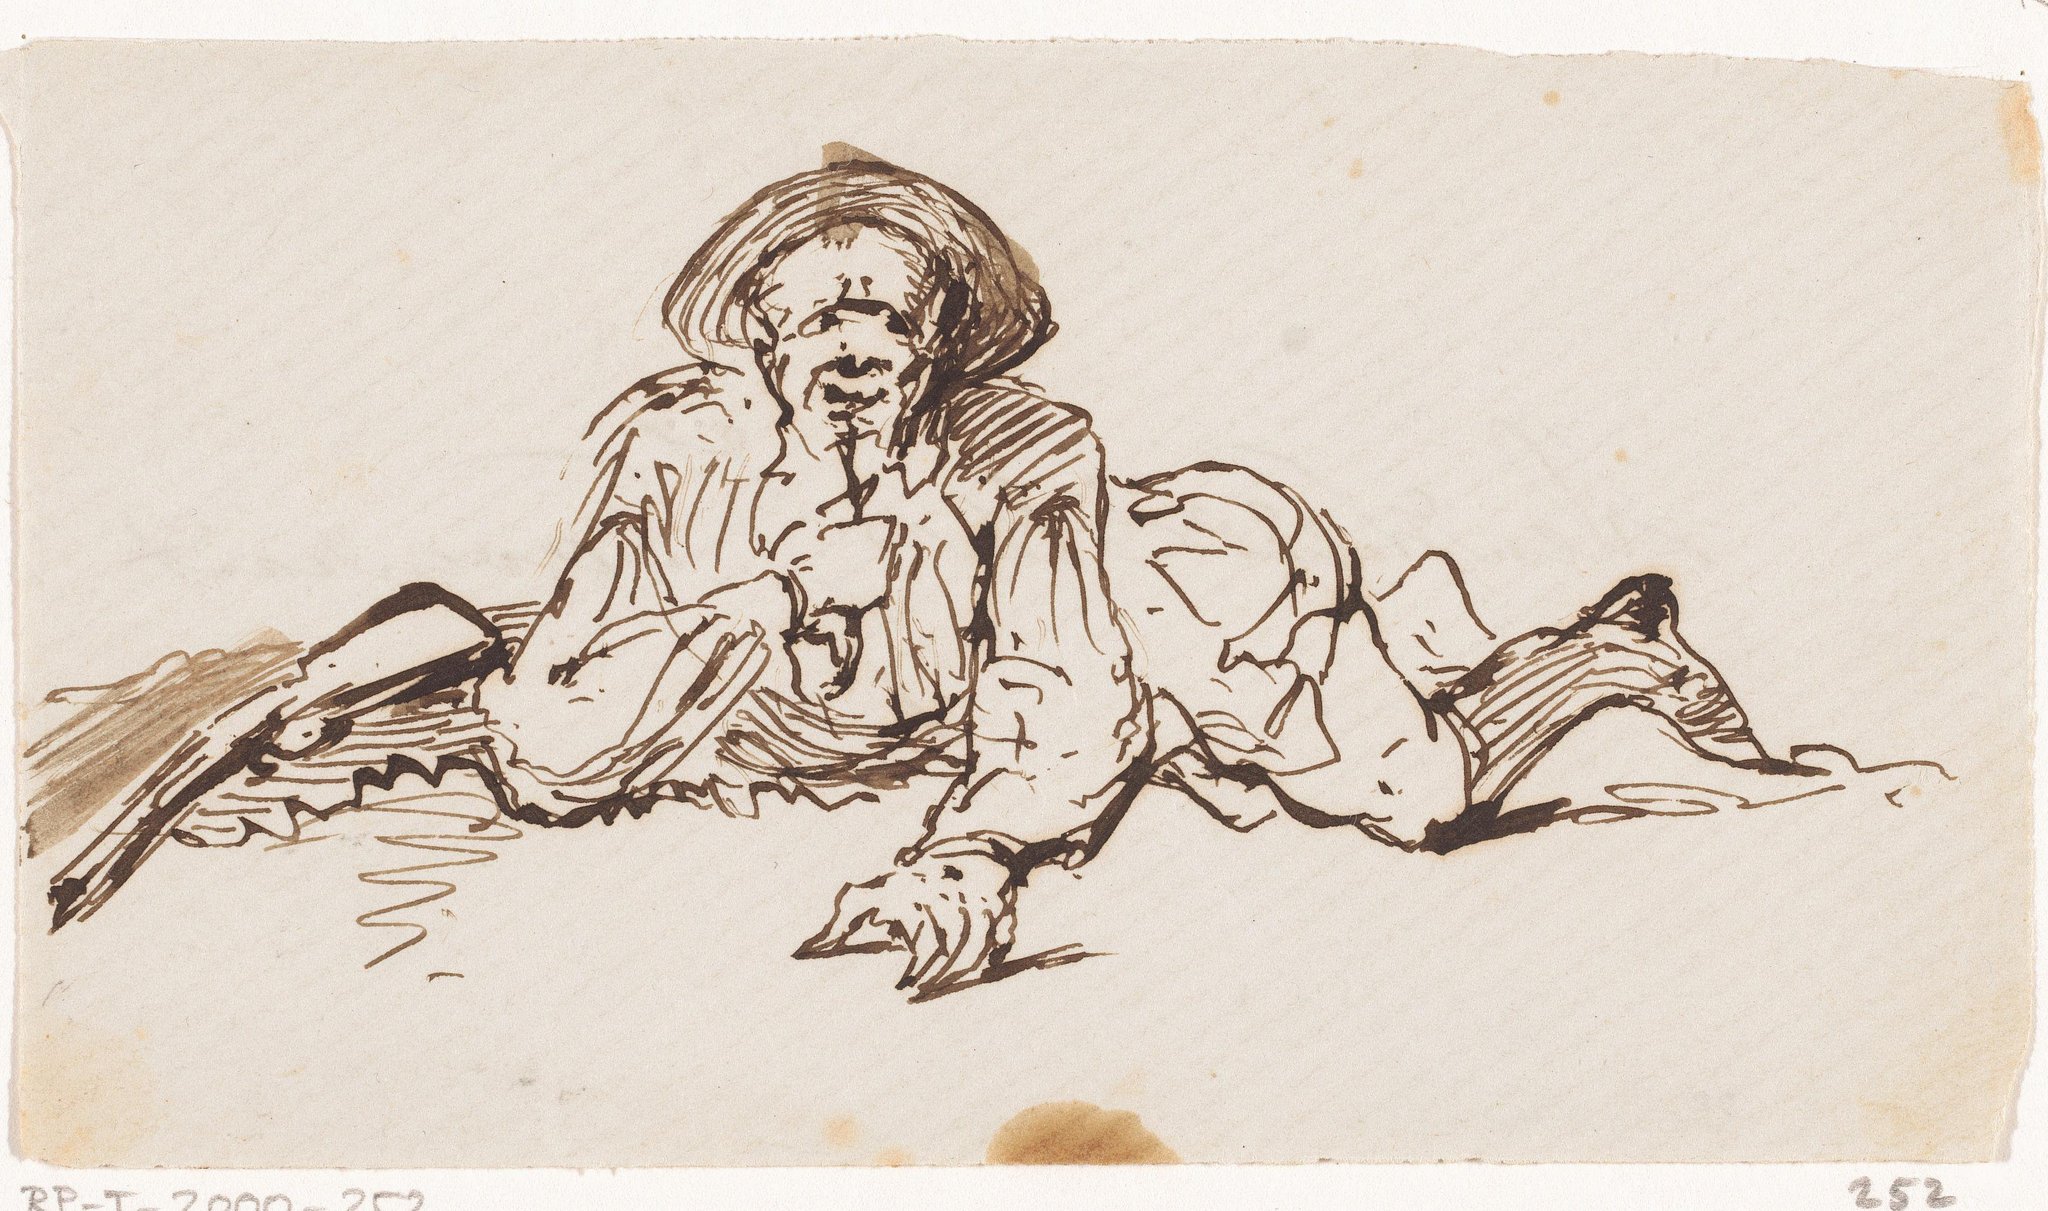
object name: drawing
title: Liggende jager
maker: johannes tavenraat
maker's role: draughtsman, painter, print maker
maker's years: 1809-1881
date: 1840-1880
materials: ink, paper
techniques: pen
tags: lying face downwards, hunter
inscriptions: collector's mark: Lugt 2228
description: Op de grond liggende, opkijkende jager. Getekend op de achterzijde van een deel van een envelop of brief geadresseerd aan Tavenraat.